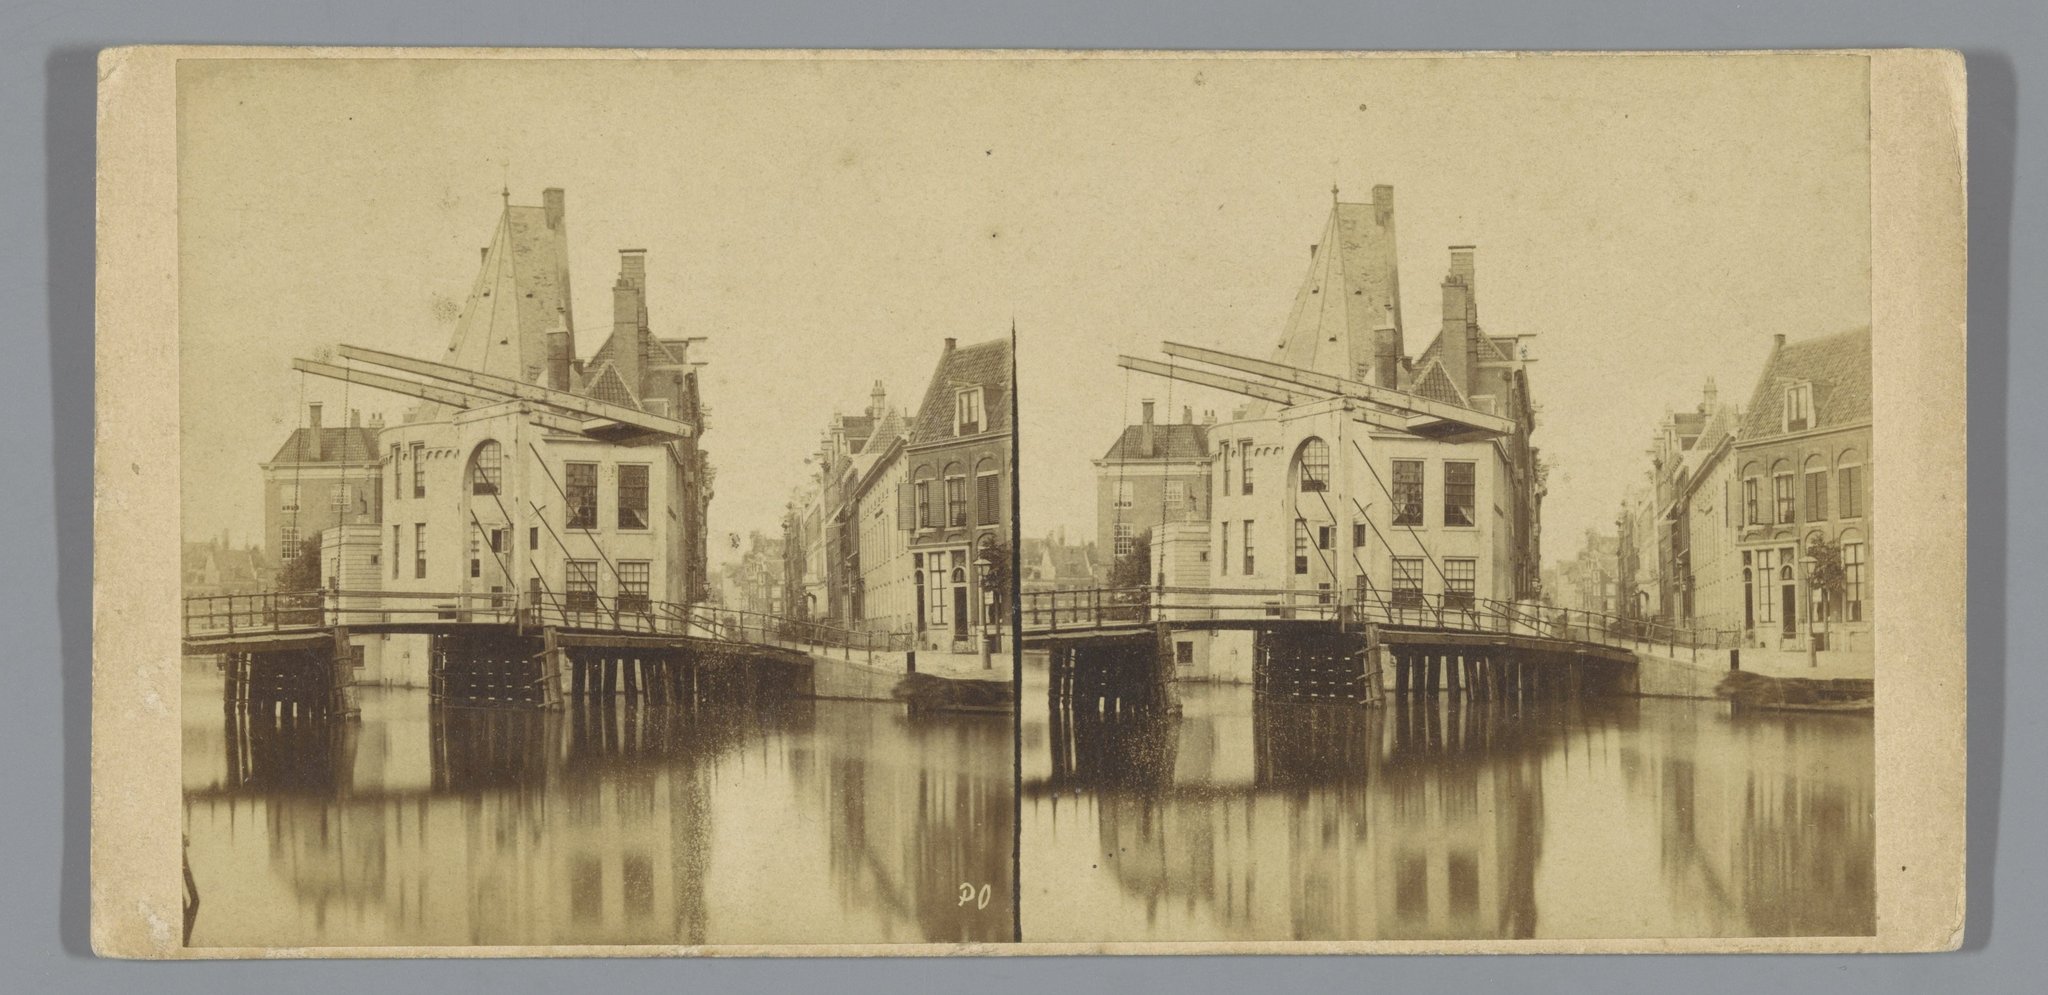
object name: stereograph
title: Vues de Hollande, Amsterdam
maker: pieter oosterhuis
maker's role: draughtsman, print maker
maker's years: 1816-1885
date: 1860-1870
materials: cardboard, paper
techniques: albumen print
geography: amsterdam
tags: bridge in city across river, canal, etc.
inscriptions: number: ‘40/ 40’, number: ‘207.’, initials: ‘P.O.’, number: ‘No 2’, inscription: ‘foto Pieter Oosterhuis’, inscription: ‘Rendorp [?]’